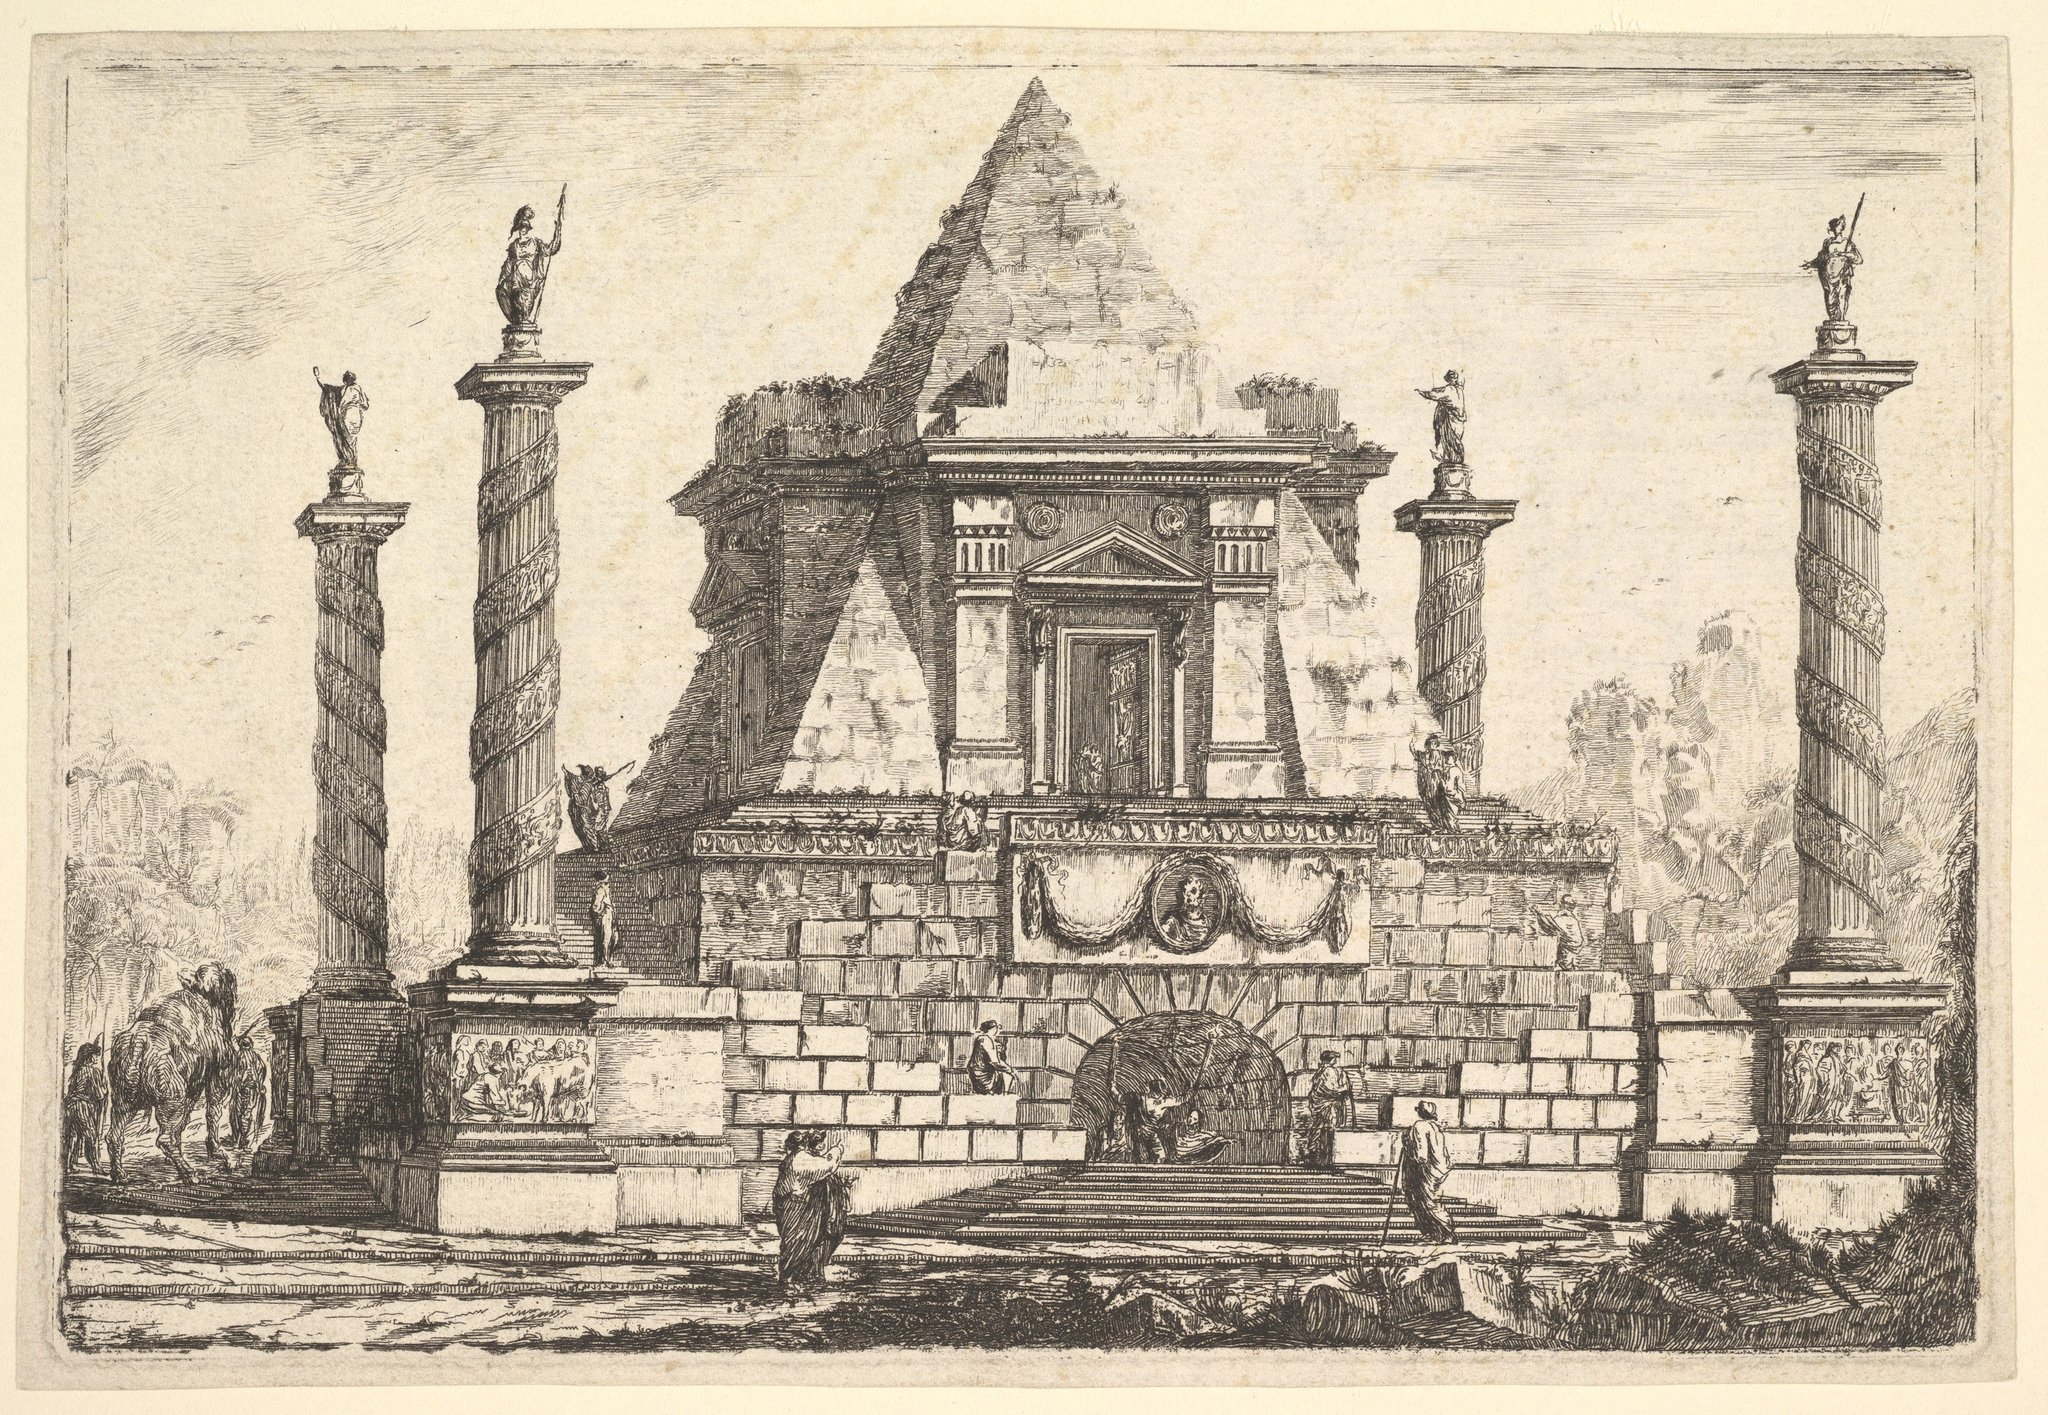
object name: print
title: Imaginary Architecture with Camel and Figures, after Della Bella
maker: pierre moreau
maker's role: artist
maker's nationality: french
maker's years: 1715-1798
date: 1701-1800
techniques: etching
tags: architecture